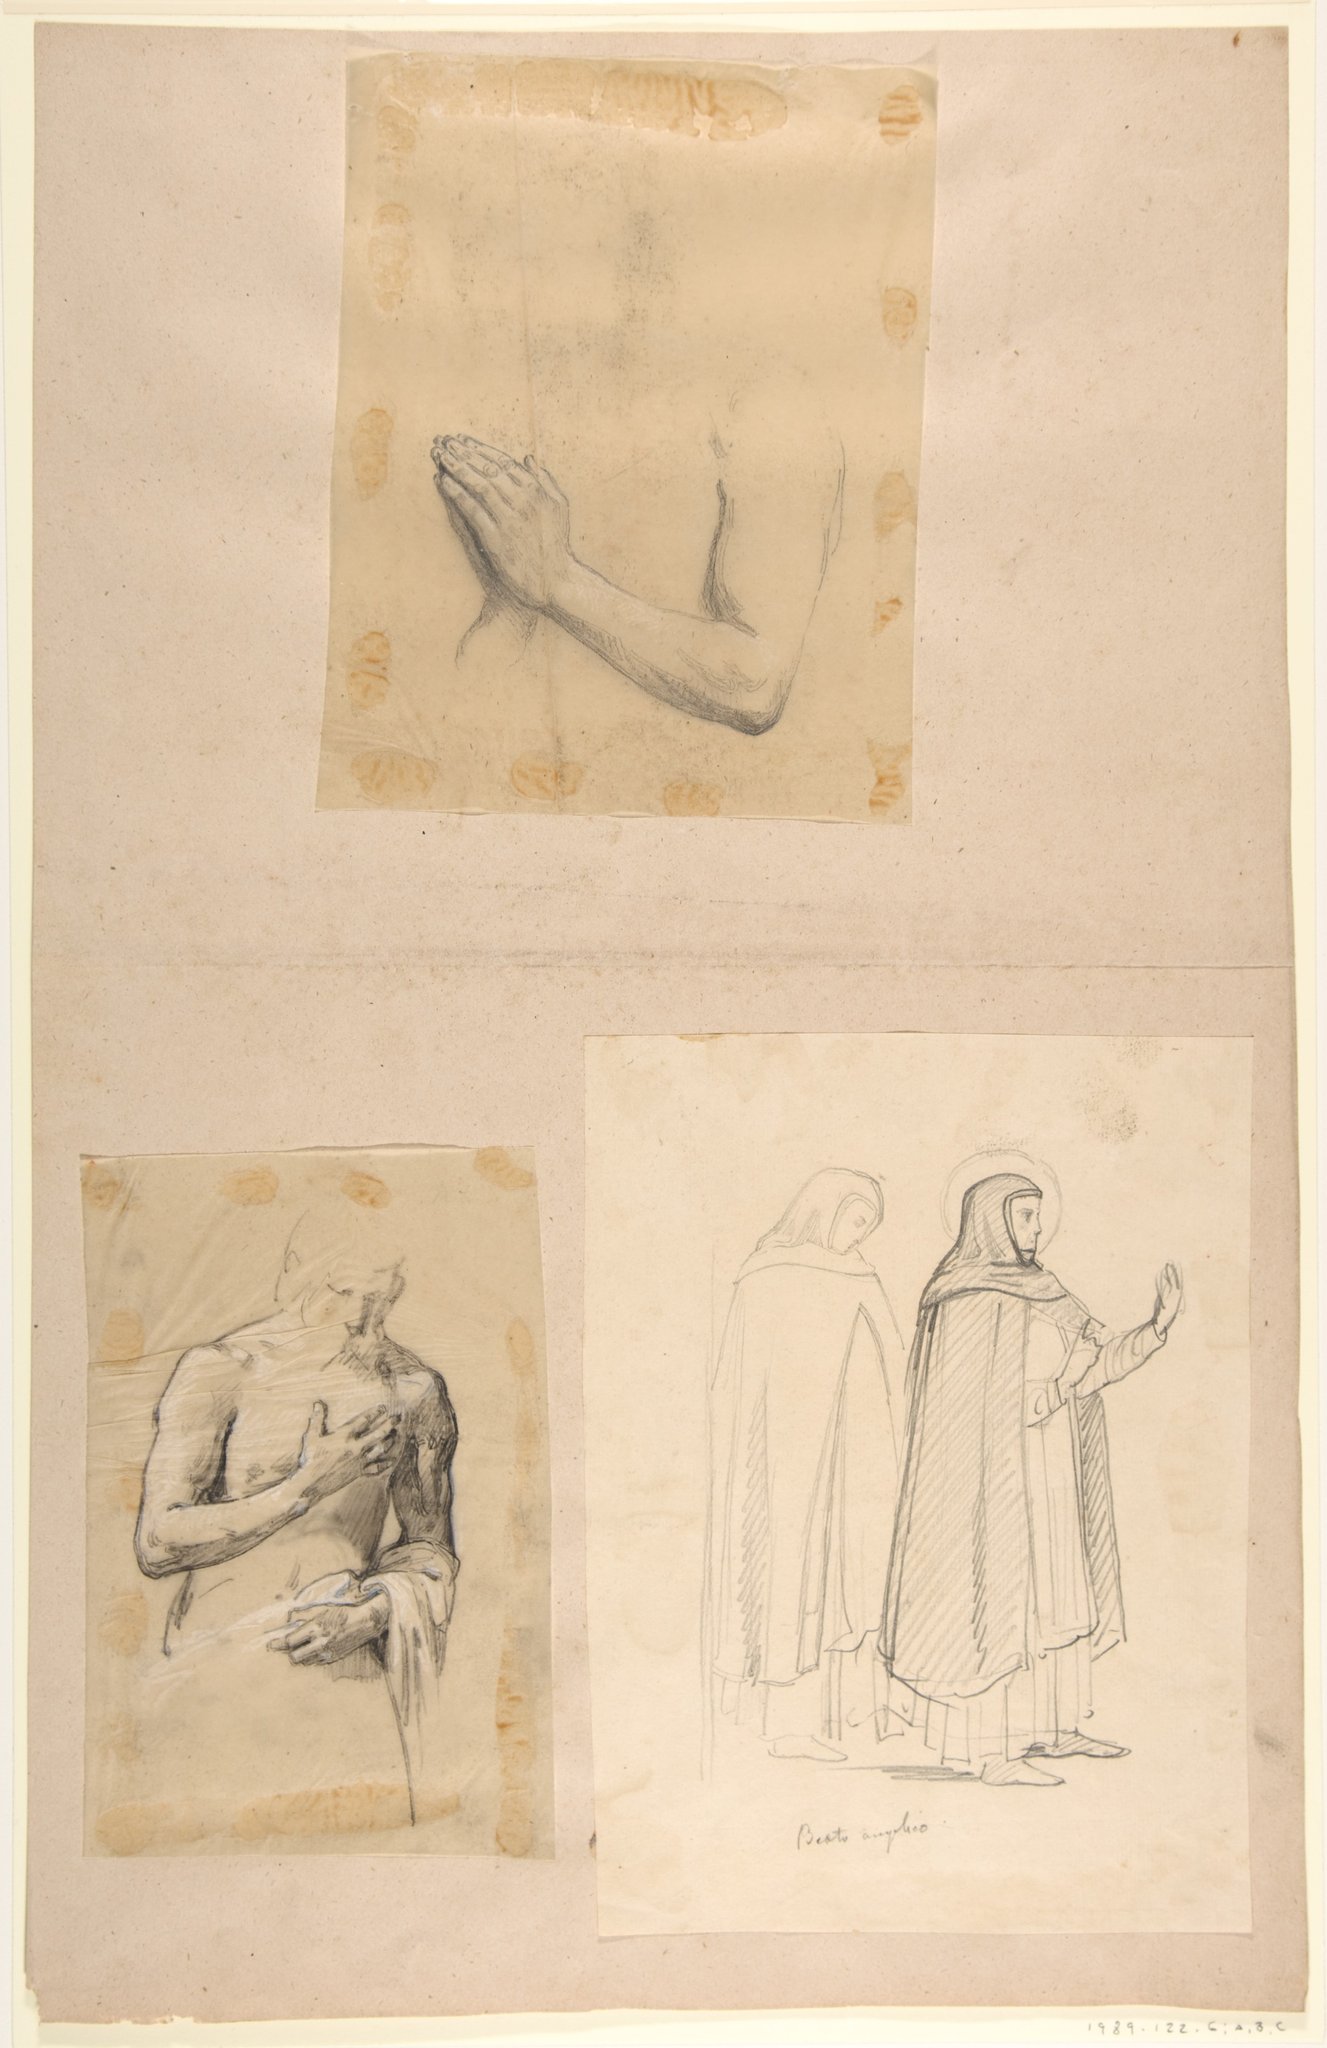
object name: drawing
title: a. Study for Clovis (middle register); b. Study for Clovis (middle register); c. St. Dominic and another Friar, after Fra Angelico; (studies for wall paintings in the Chapel of Saint Remi, Sainte-Clotilde, Paris, 1858)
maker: isidore pils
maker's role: artist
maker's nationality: french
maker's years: 1813-1875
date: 1801-1900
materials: chalk, graphite, paper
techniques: heightening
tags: hands,men,saints